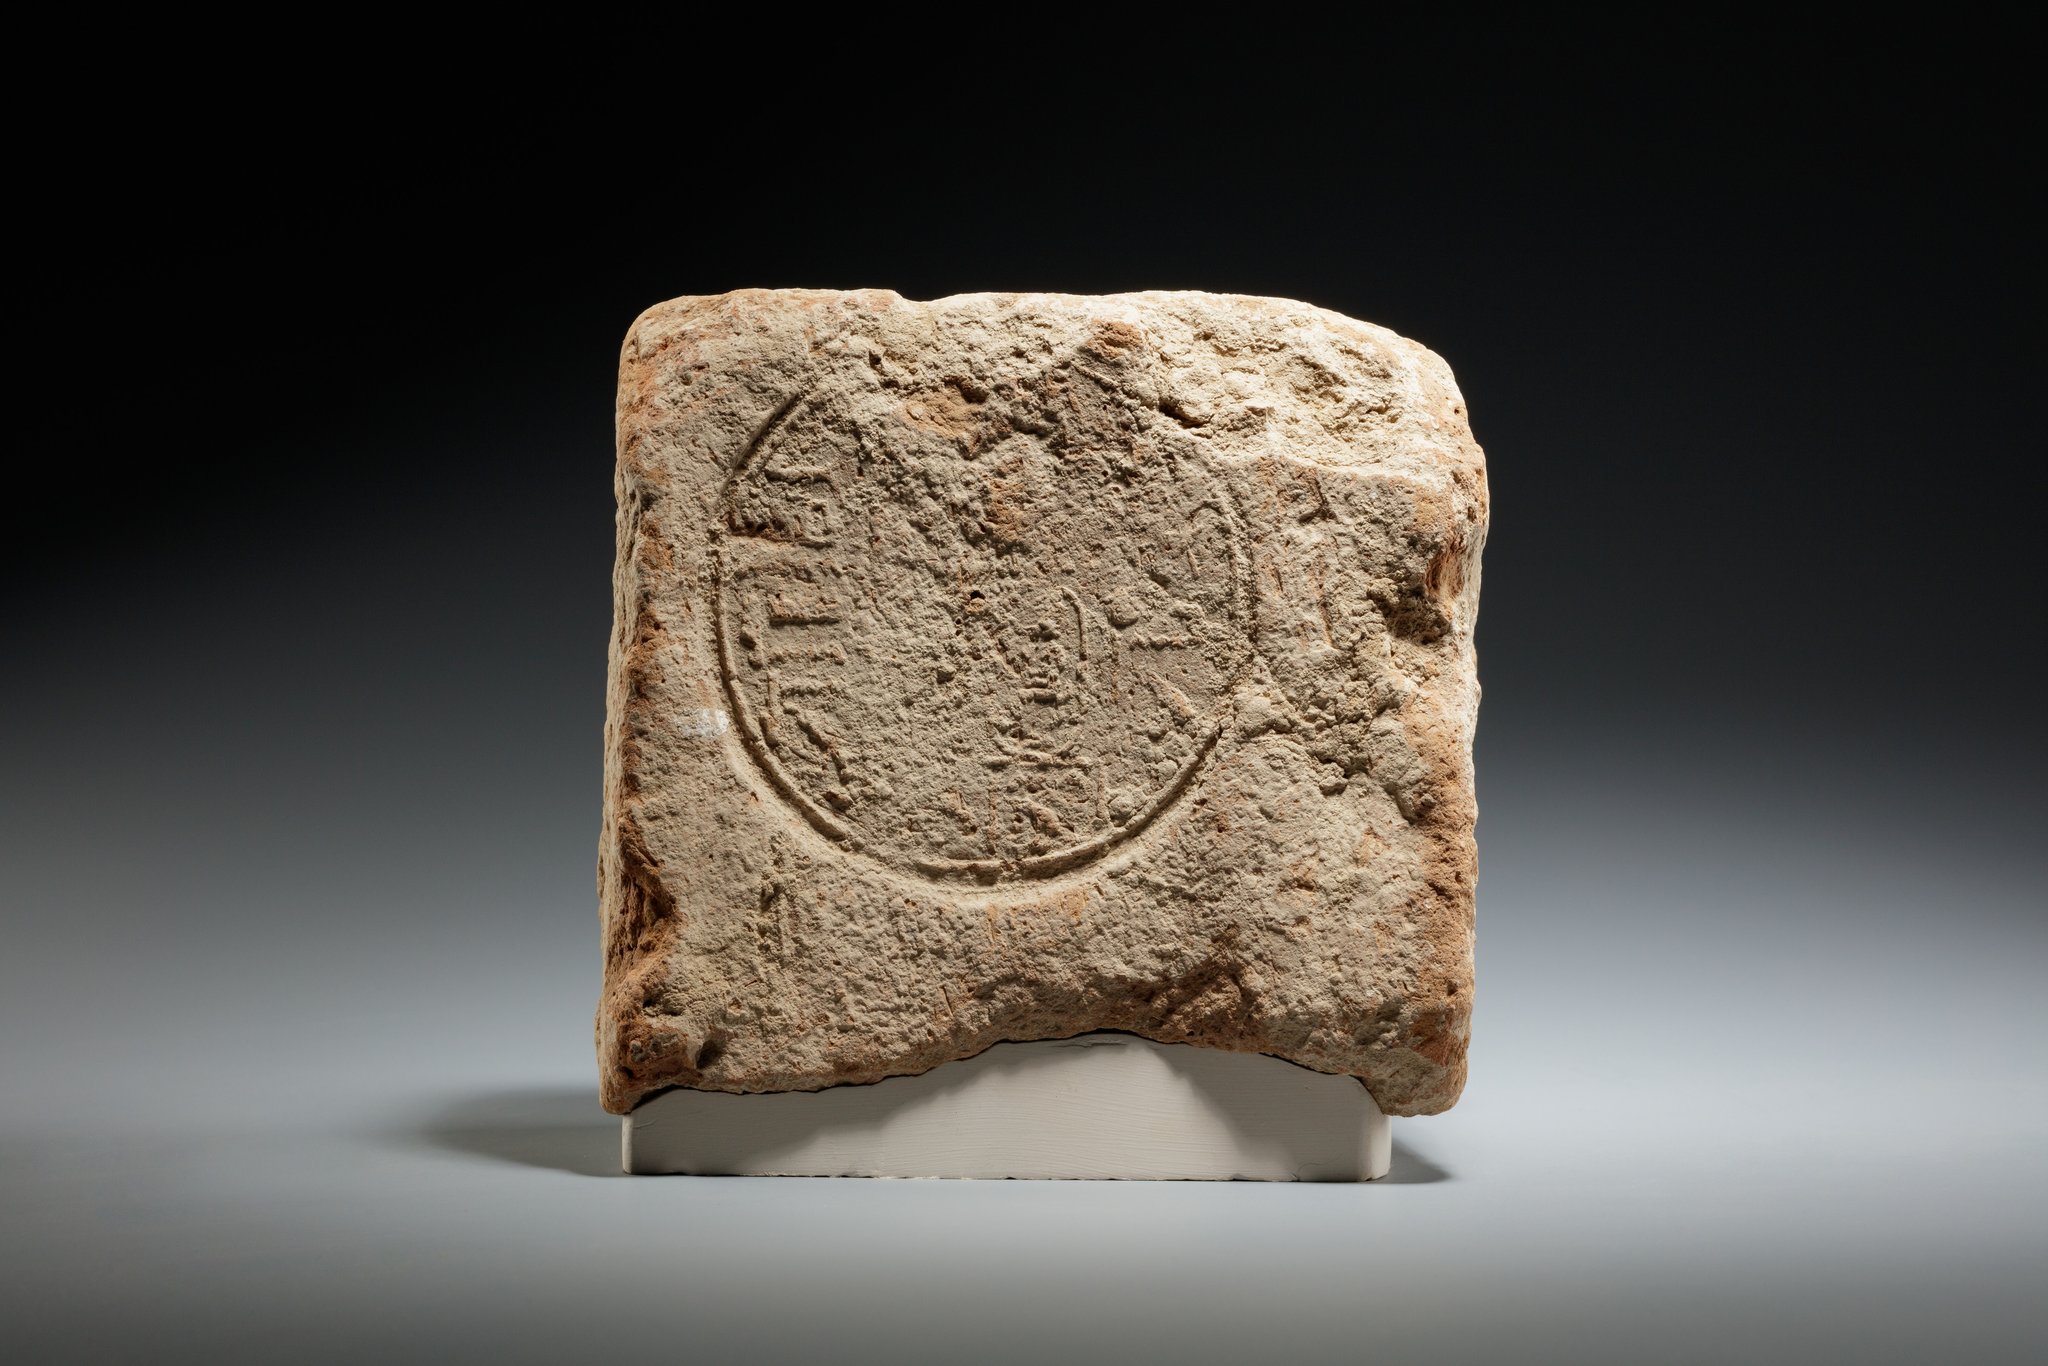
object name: cone, brick, davy 88, senenmut, tt 71, double granary, amun, hatshepsut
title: Mud Brick Stamped with the Name and Titles of Senenmut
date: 1479-1458 BCE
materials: pottery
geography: egypt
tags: hieroglyphs